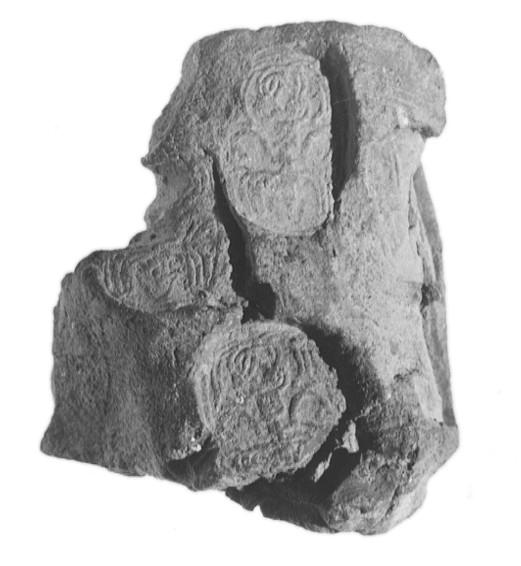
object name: sealing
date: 2030-1640 BCE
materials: clay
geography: egypt